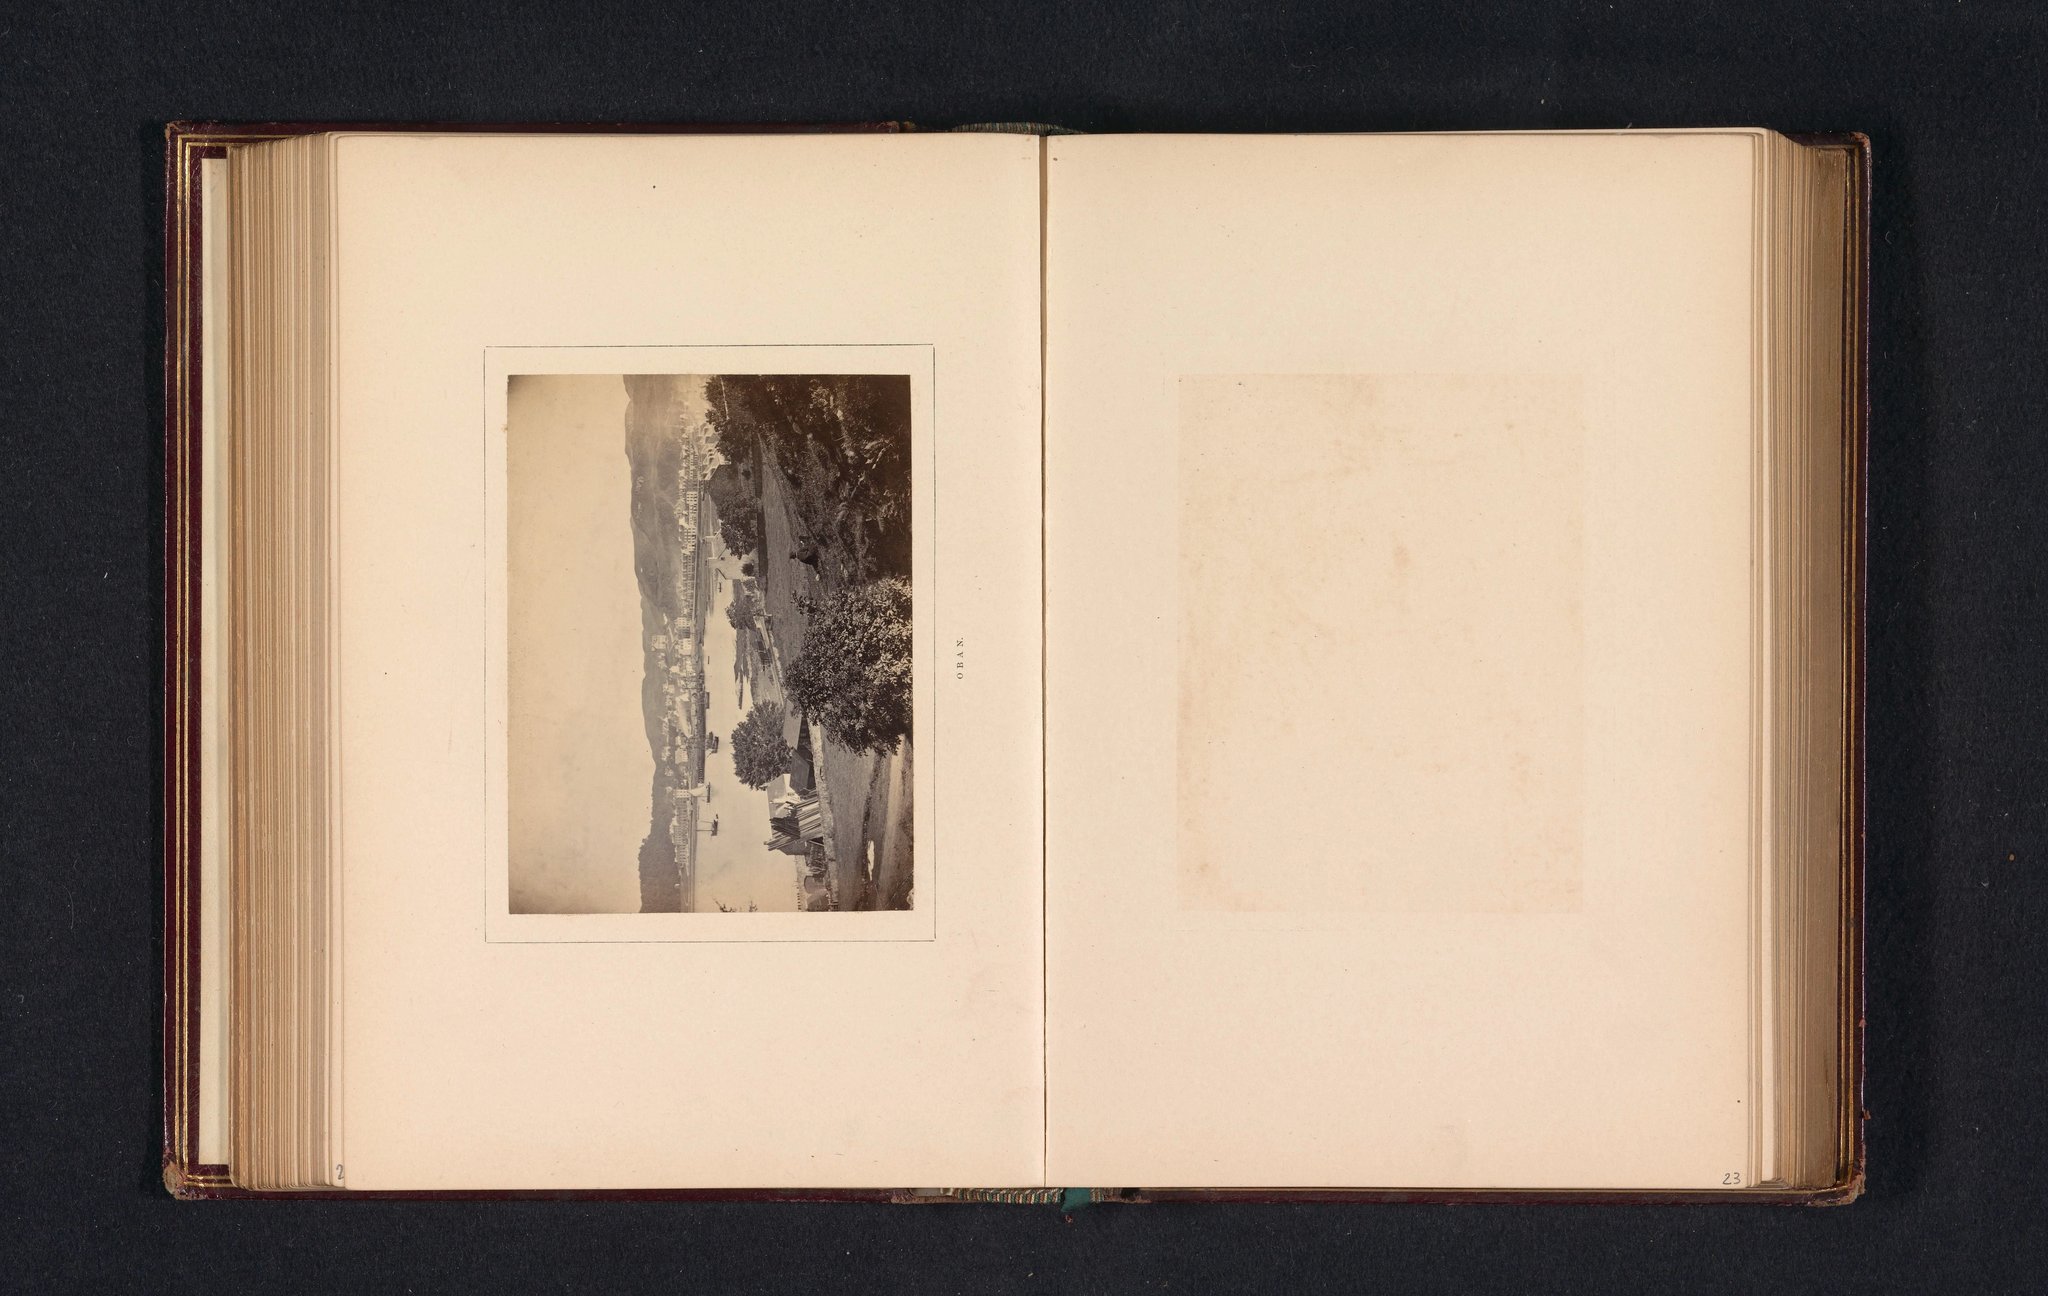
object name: photograph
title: Oban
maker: george washington wilson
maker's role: publisher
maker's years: 1823-1893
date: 1858-1868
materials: photographic support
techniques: albumen print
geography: scotland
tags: harbour, city-view, and landscape with man-made constructions